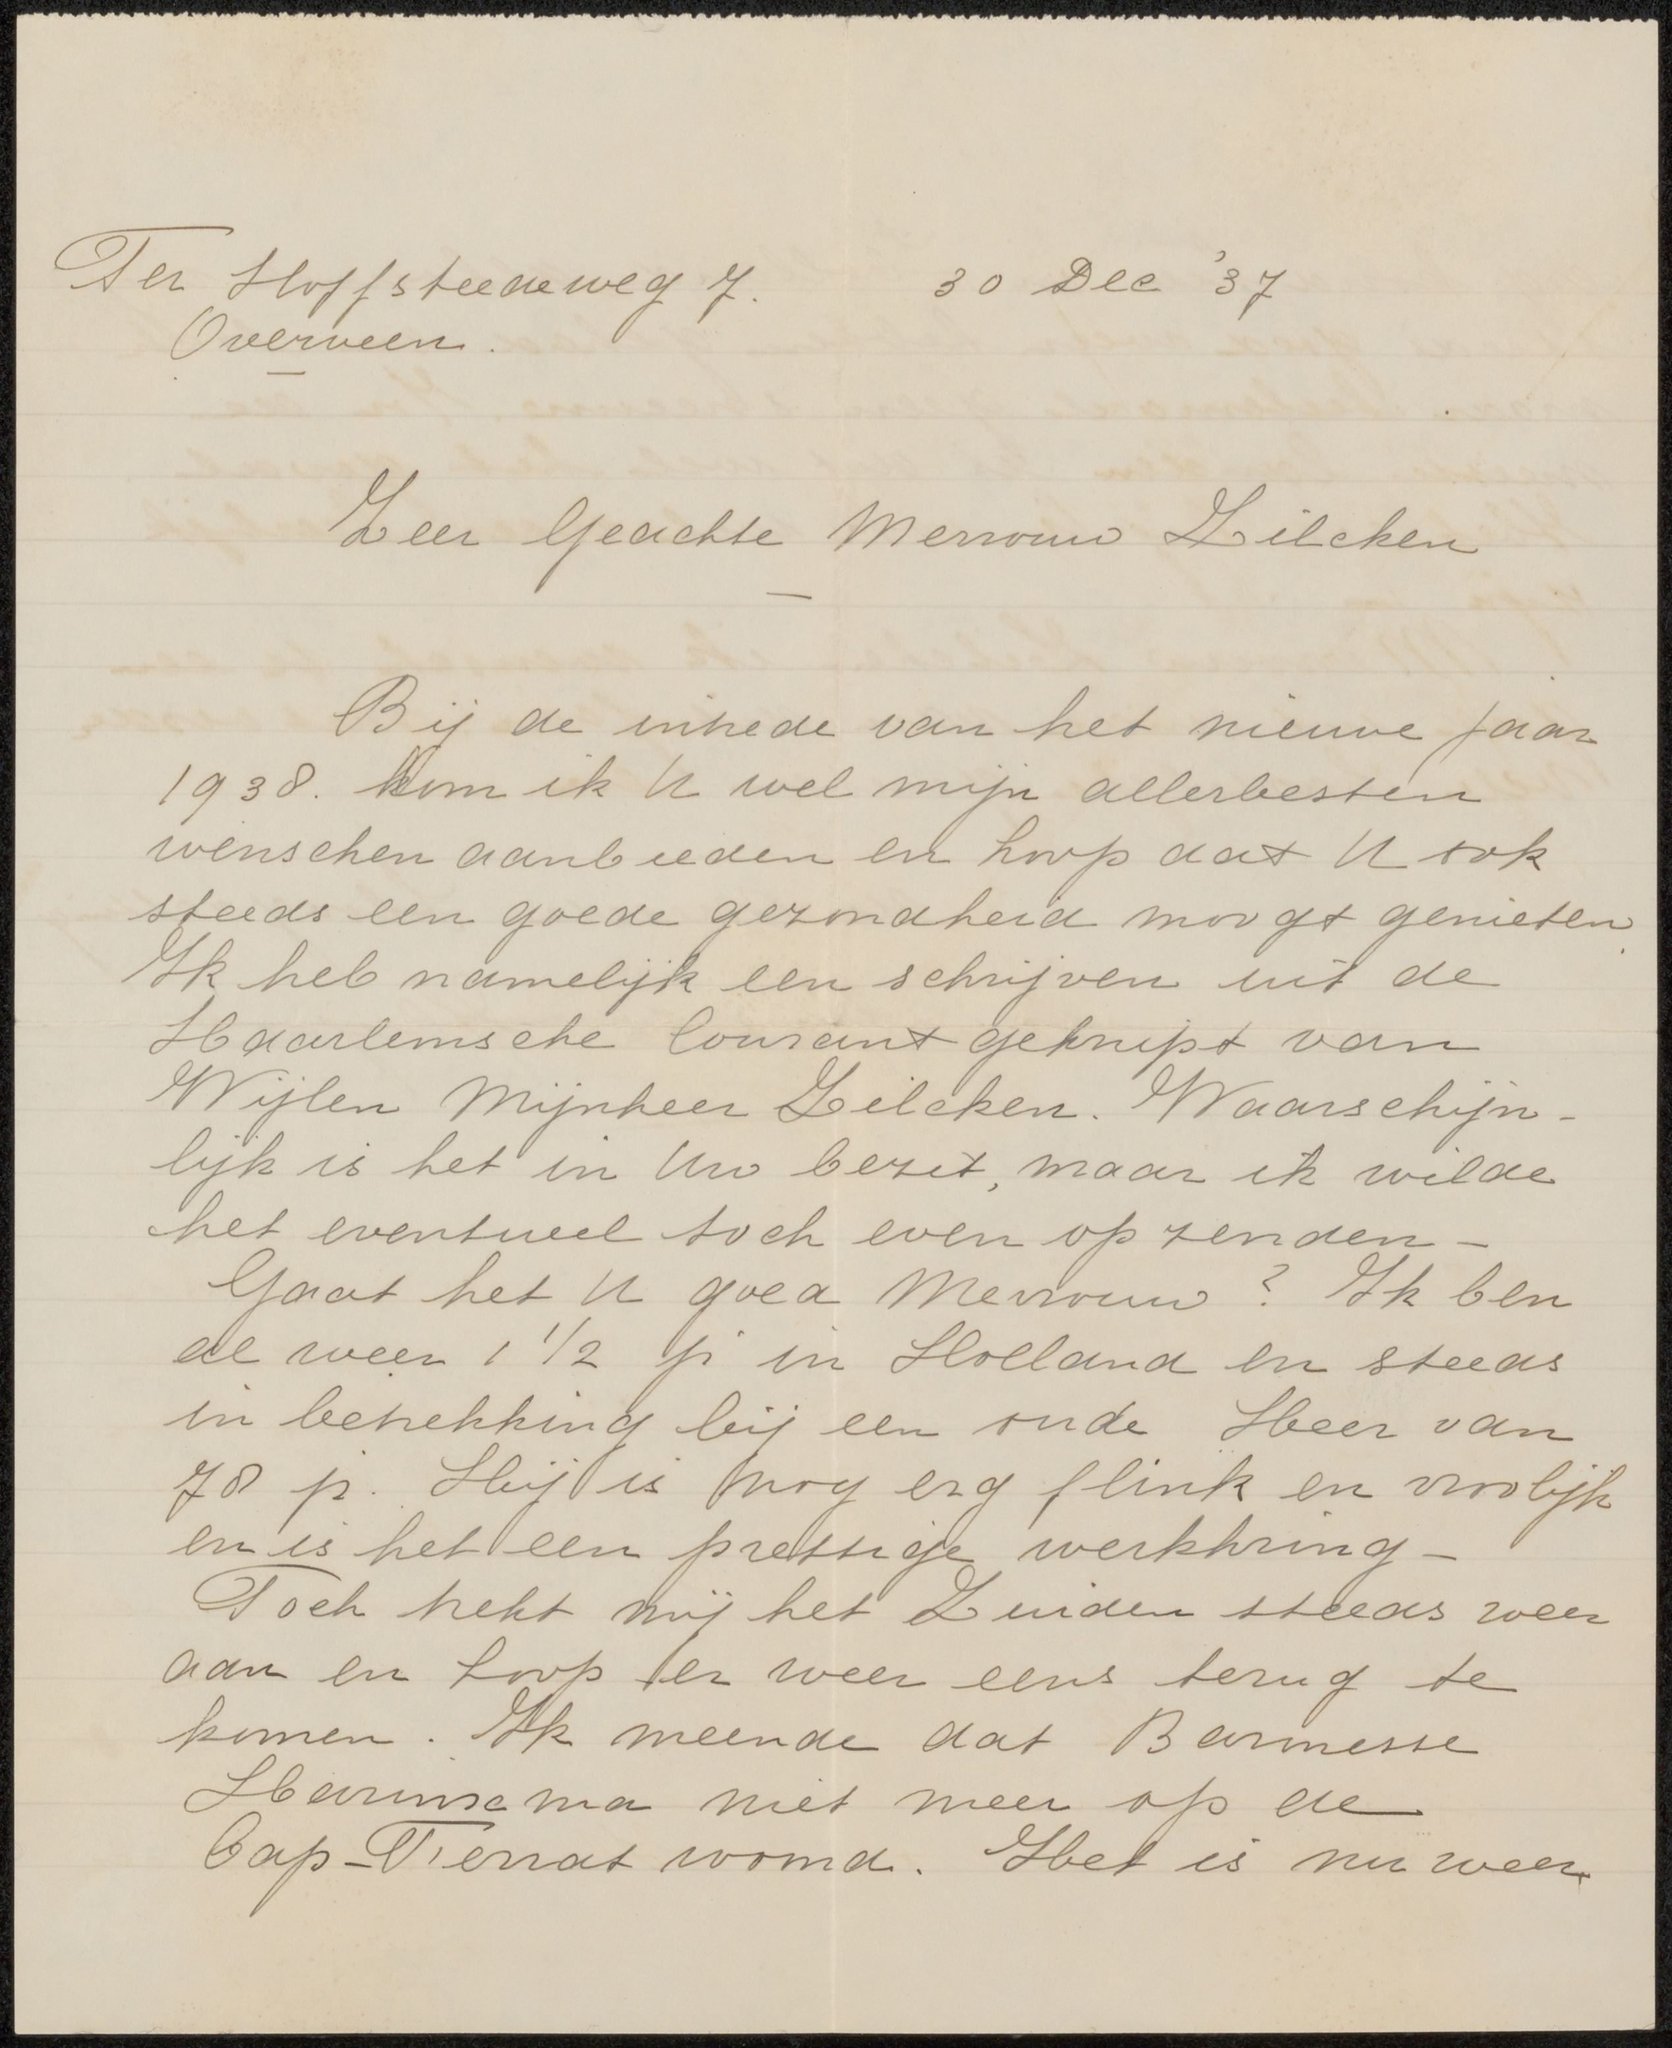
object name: letter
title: Brief aan Henriette Wilhelmina van Baak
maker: jacoba heijnen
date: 1937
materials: ink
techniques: pen, writing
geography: overveen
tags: henriette wilhelmina van baak, the hague, painter, draughtsman, philip zilcken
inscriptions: collector's mark: ‘RPK’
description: Samen met deze brief is artikel RP-D-1982-43-HEIJNEN(JACOBA)-DOC.1 verstuurd.